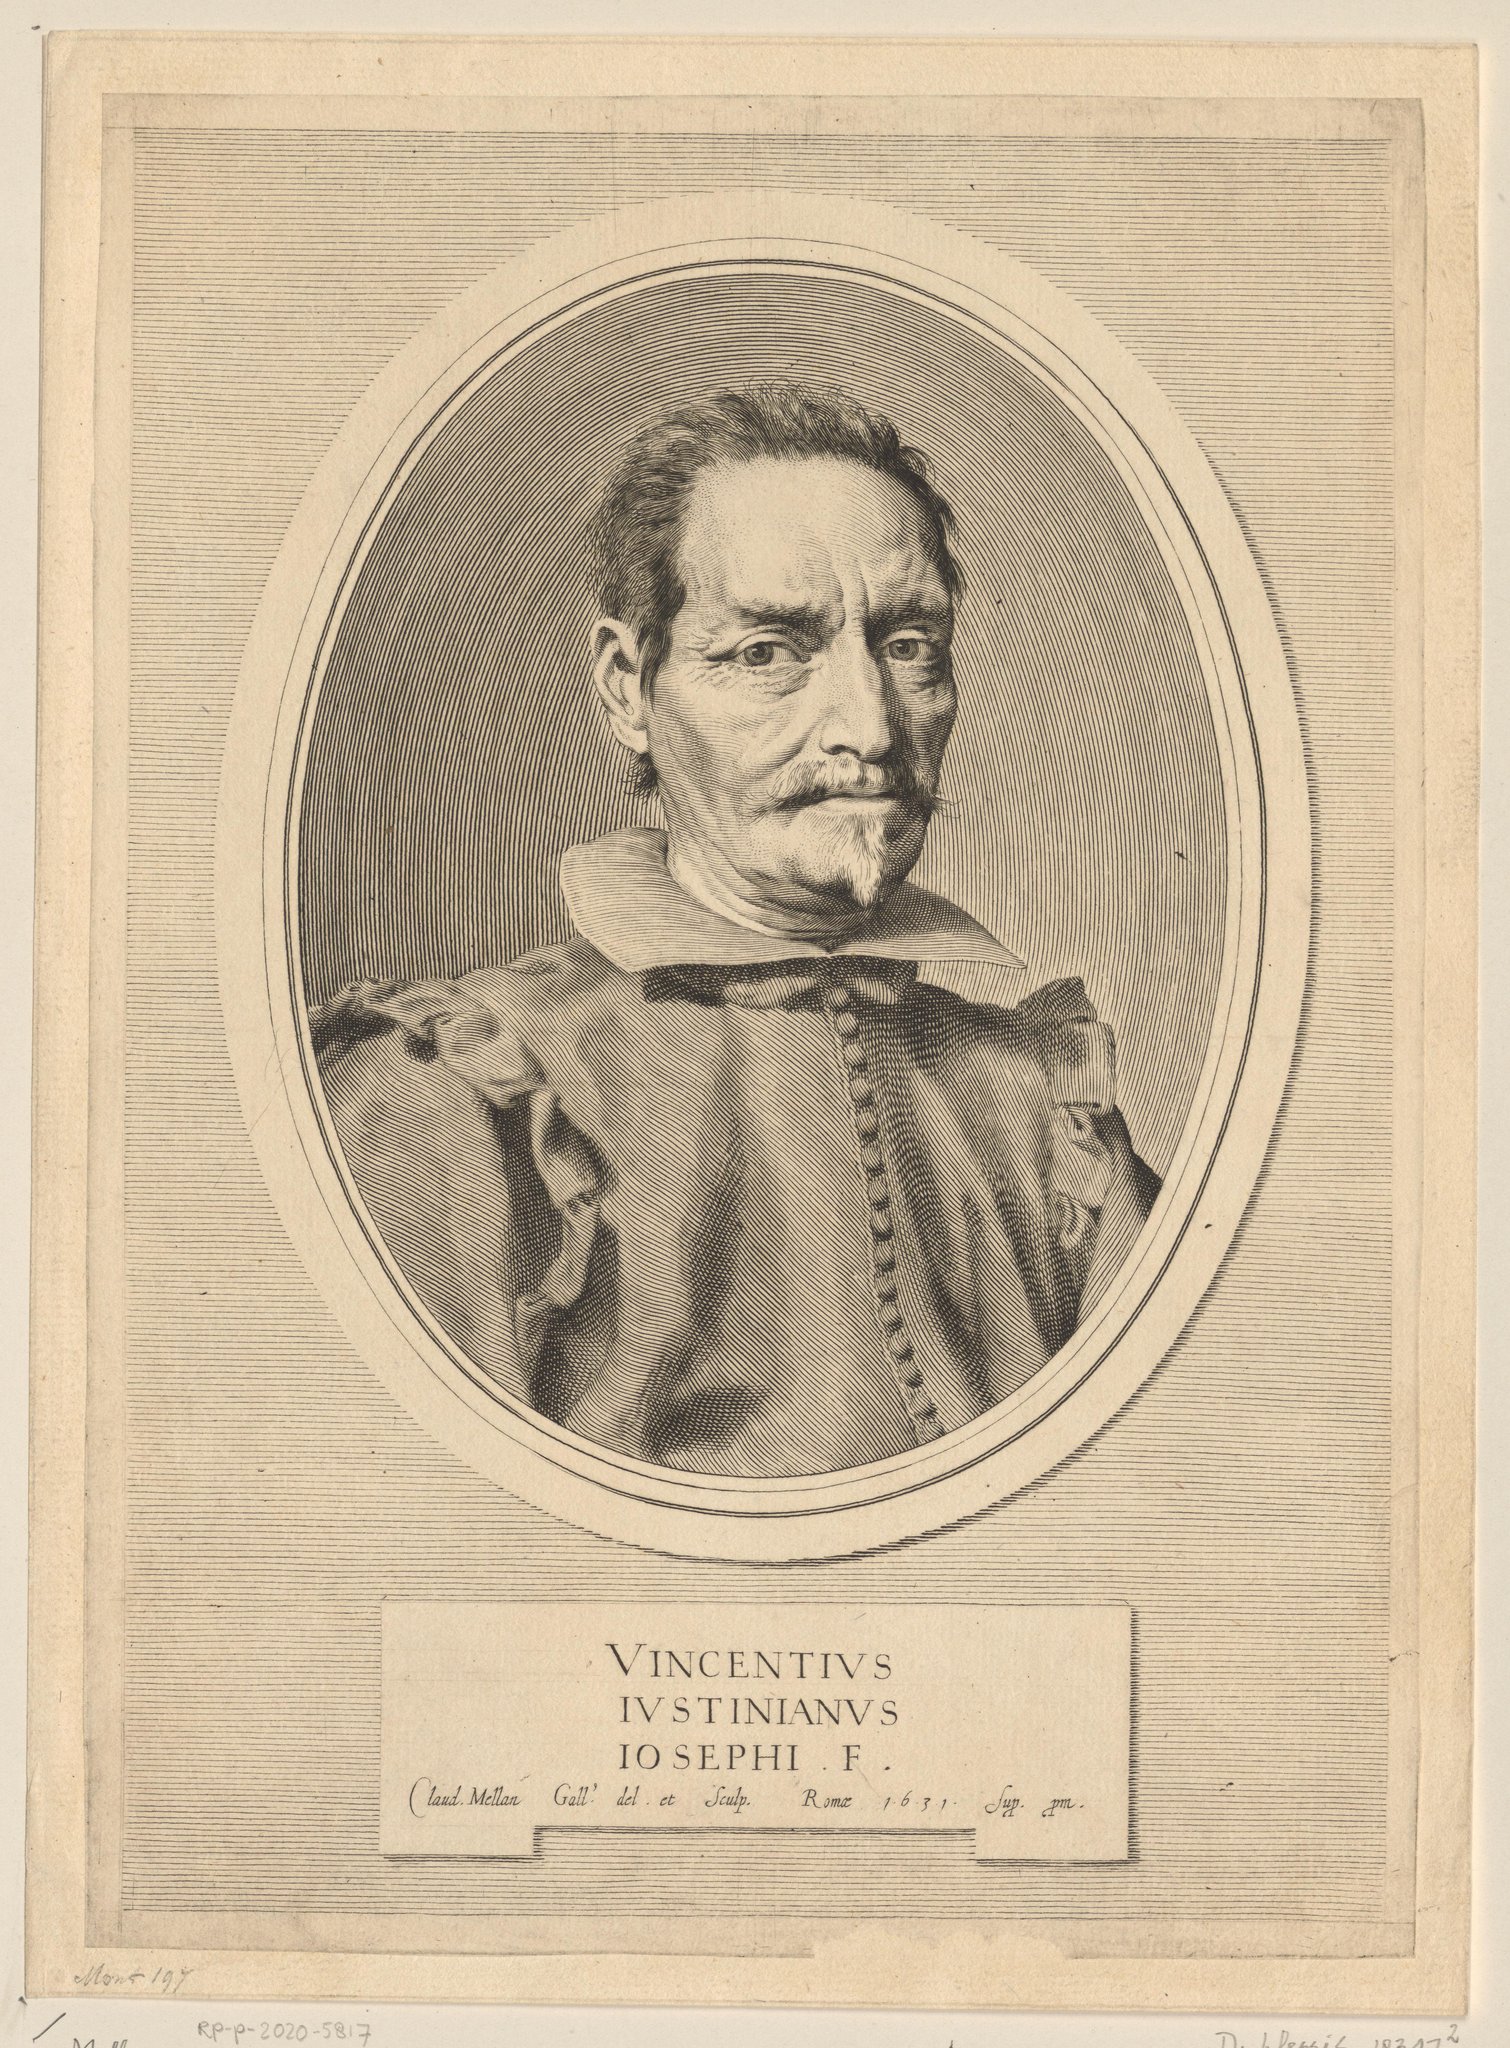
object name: print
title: Portret van Vincenzo Giustiniani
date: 1631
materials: paper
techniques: engraving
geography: italy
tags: rome, vincenzo giustiniani (1564-1637), banker, historical persons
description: Maakt deel uit van een serie bestaande uit 322 prenten van kunstwerken uit de collectie van Vincenzo Giustiniani die in twee volumes werd uitgegeven door Joachim von Sandrart in 1636 en 1637 (zie British Museum, inv.nr. 1851,1213.565). De serie bestaat uit prenten door verschillende kunstenaars zoals Cornelis Bloemaert, Theodore Matham, Pieter de Bailliu en Michel Natalis. Claude Mellan was verantwoordelijk voor 22 prenten van standbeelden en het 1631 gedateerde portret van Giustiniani. De voorbereidende tekening bevindt zich in de collectie van de Albertina te Wenen, inv. nr. 11471.